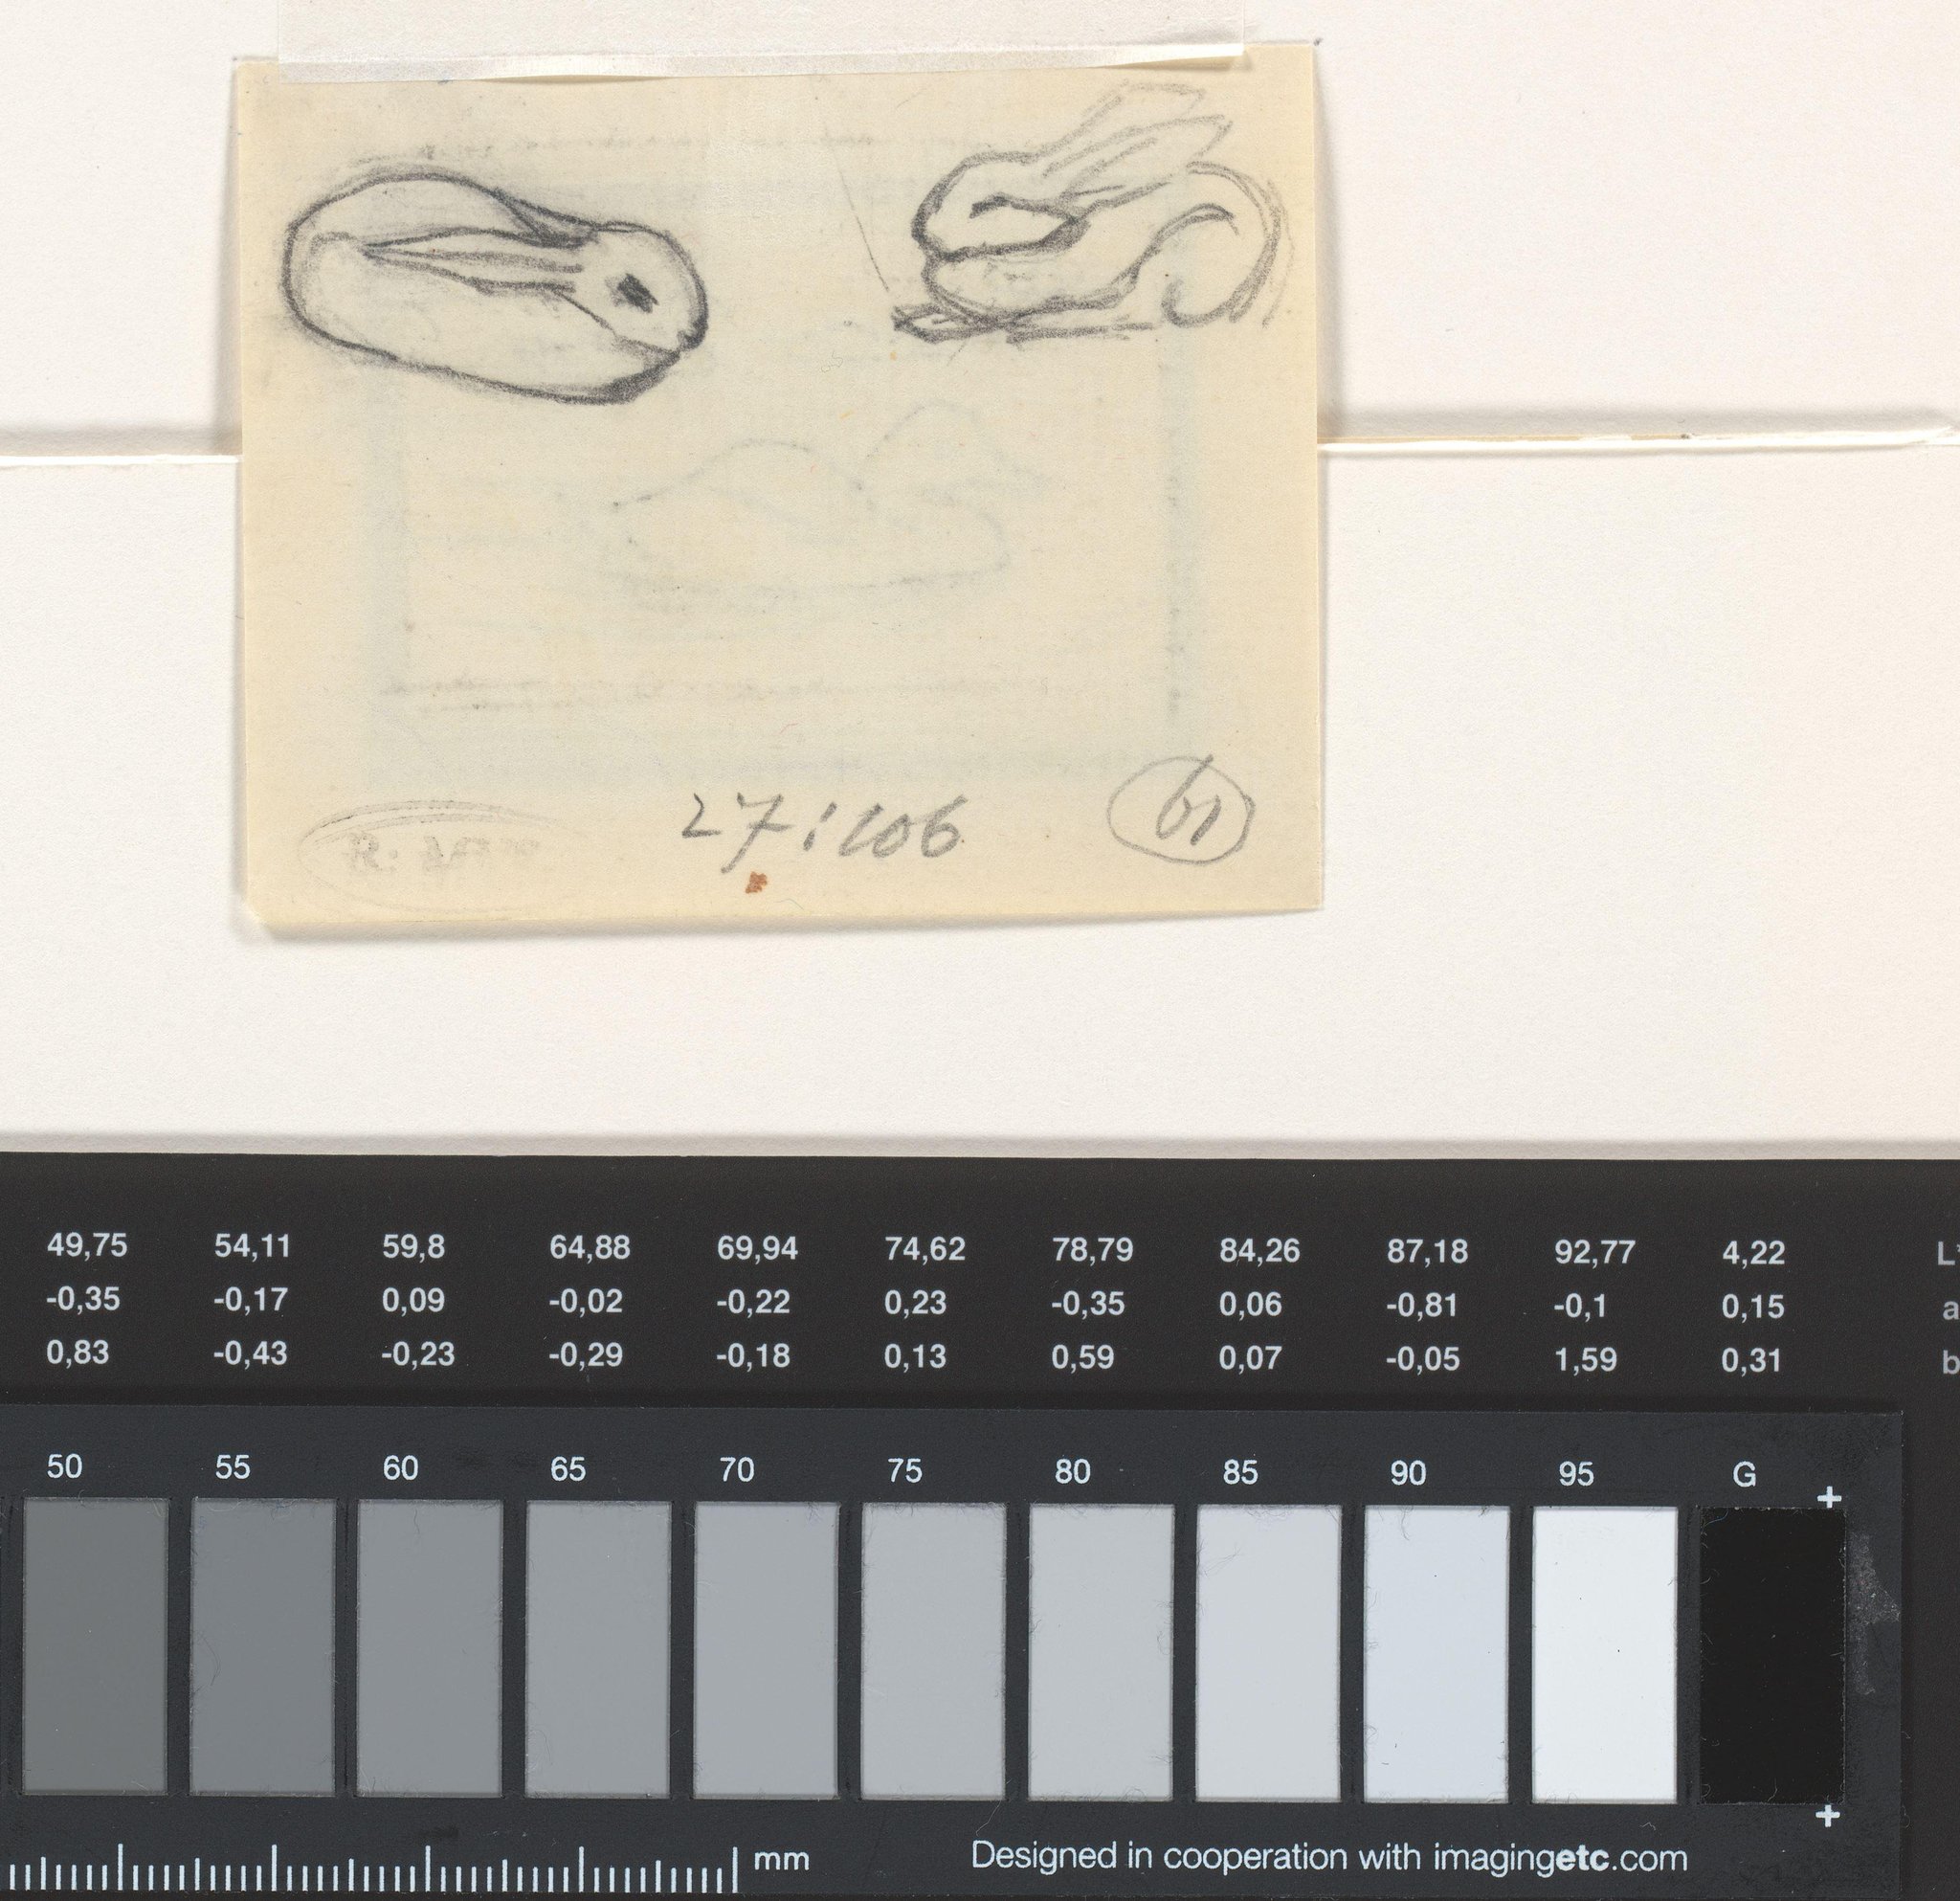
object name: drawing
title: Twee zittende konijnen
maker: julie de graag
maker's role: draughtsman, print maker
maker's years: 1877-1924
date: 1887-1924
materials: paper, pencil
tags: rodents: rabbit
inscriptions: number: ‘61’